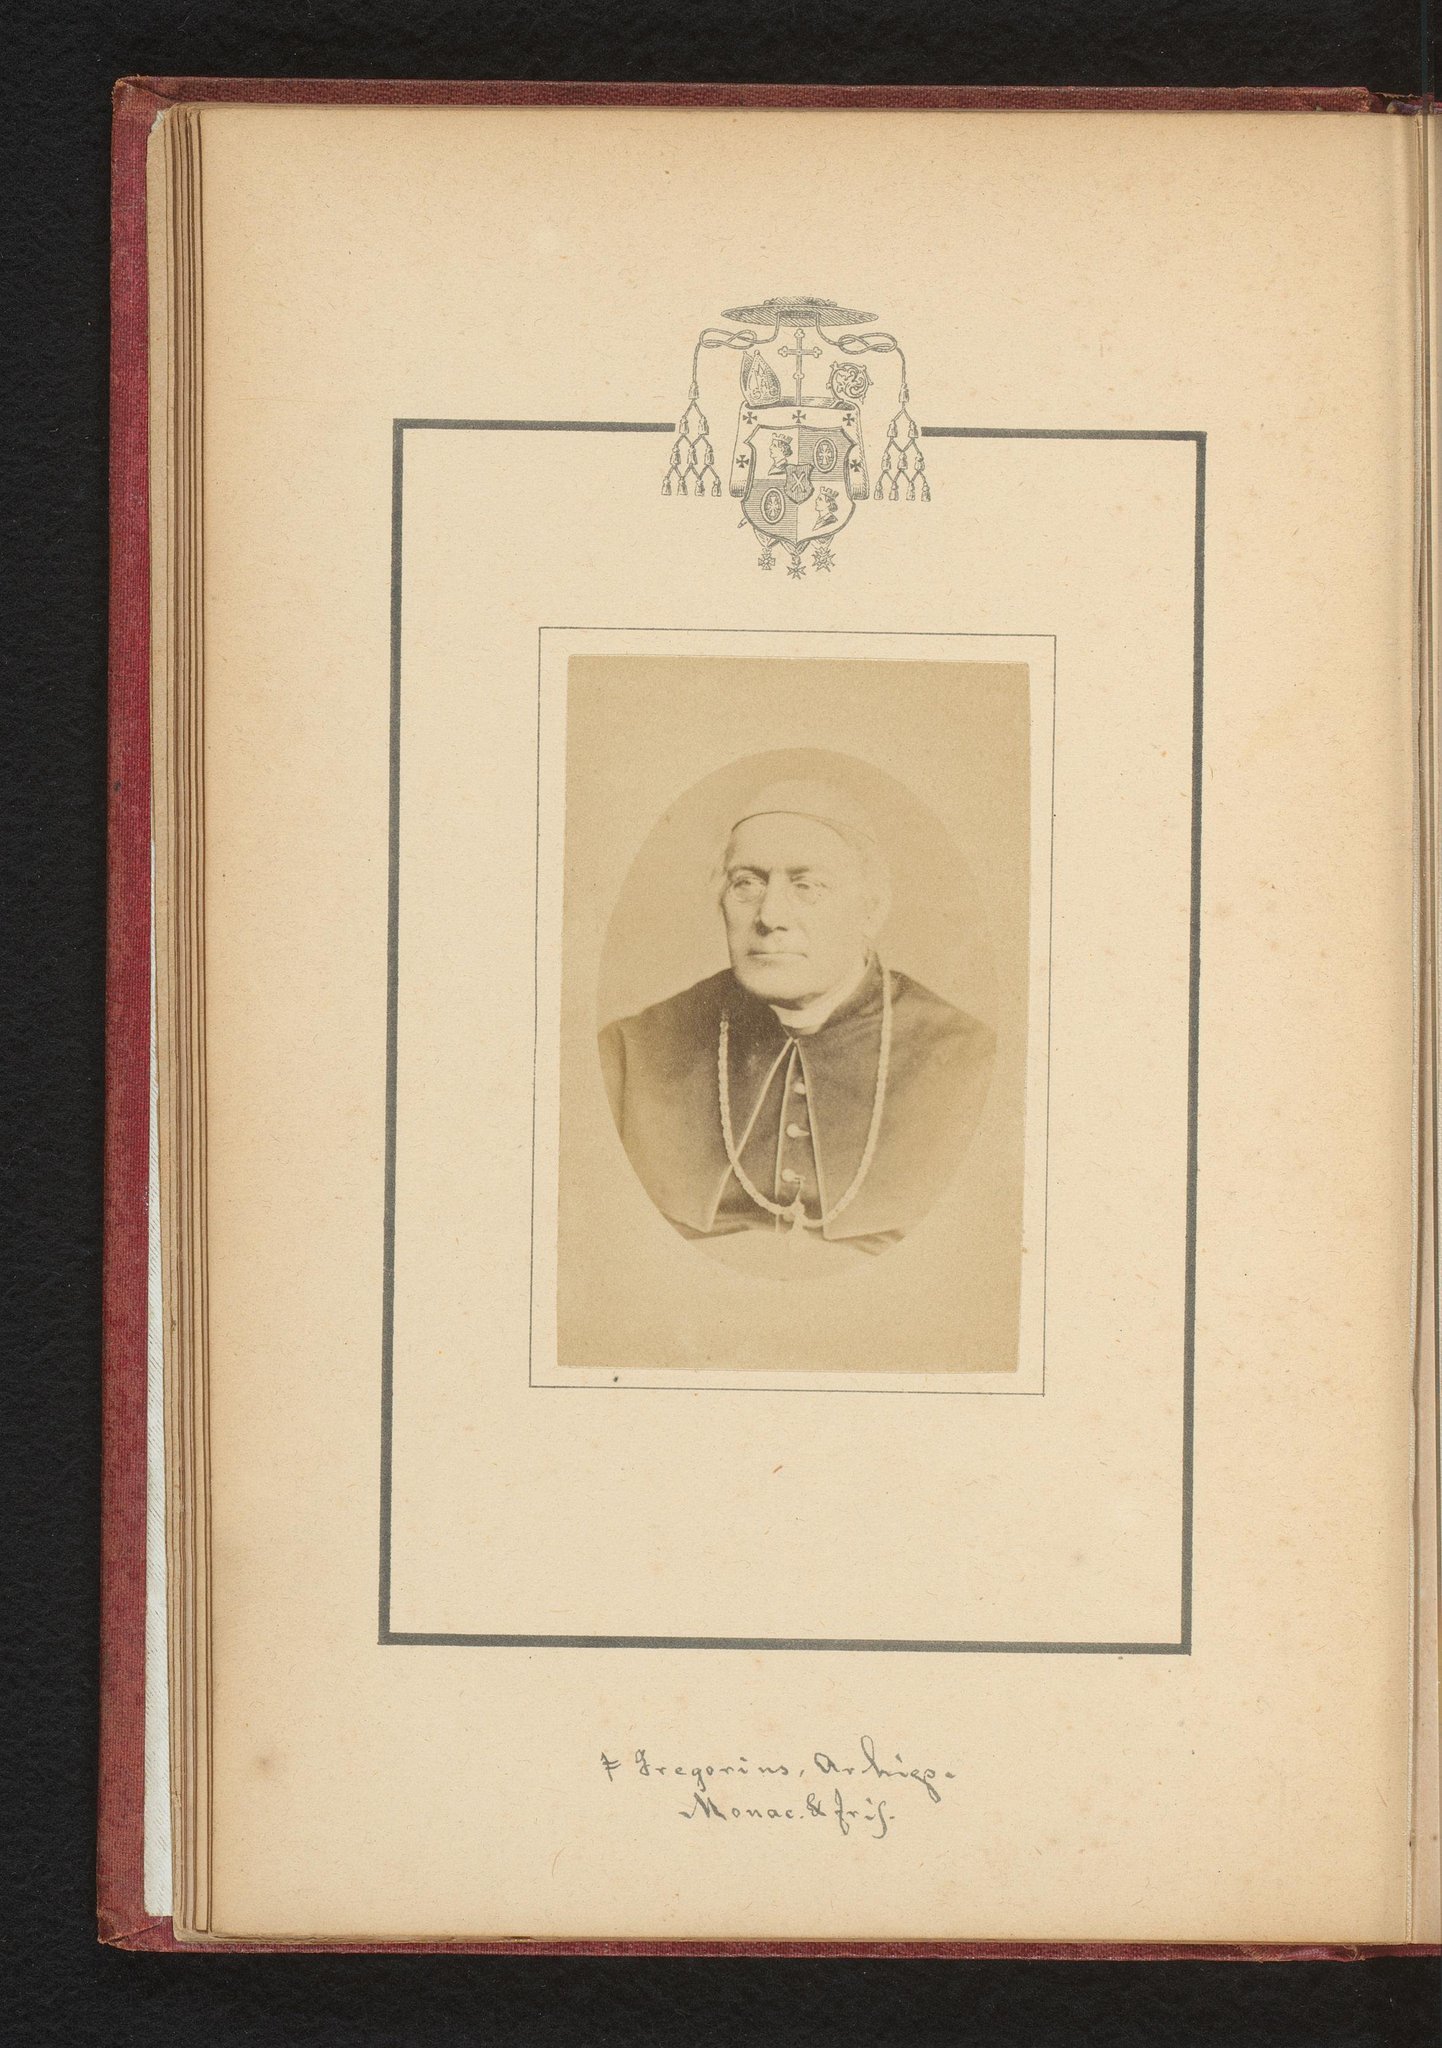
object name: photograph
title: Portret van aartsbisschop Gregor von Scherr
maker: Anonymous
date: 1863-1873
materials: photographic support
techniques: albumen print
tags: archbishop, bishop, etc. (roman catholic)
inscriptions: inscription: ‘Gregorius, ar[...] Monac. & [...]’